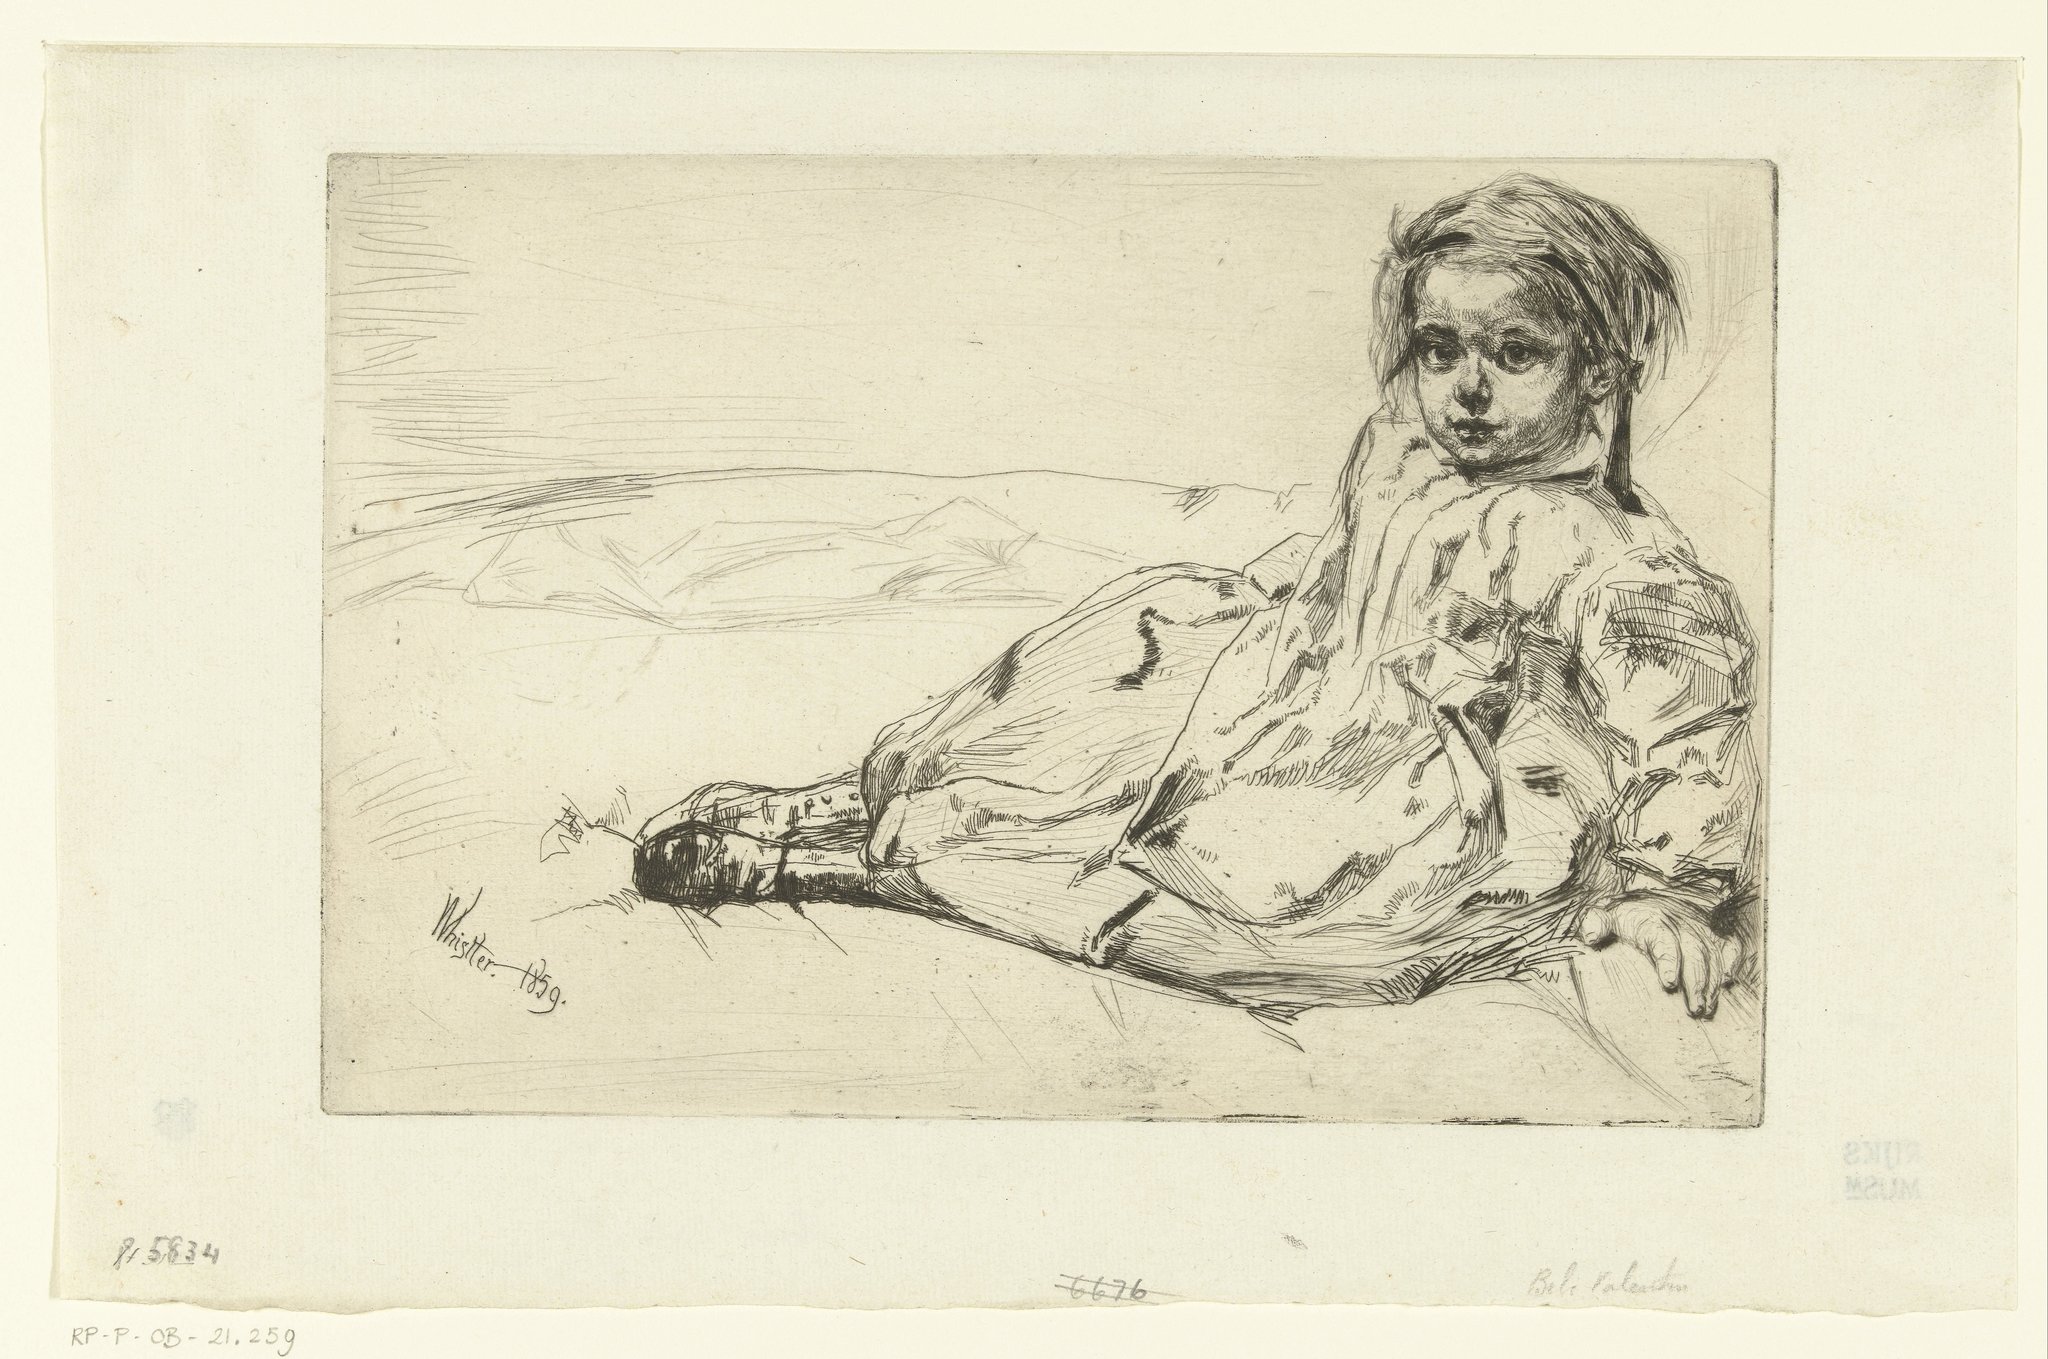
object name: print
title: Portret van Bibi Valentin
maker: james abbott mcneill whistler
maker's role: painter, print maker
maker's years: 1834-1903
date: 1859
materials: paper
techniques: etching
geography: england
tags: bibi valentin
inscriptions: collector's mark: Lugt 2166, collector's mark: Lugt 2760